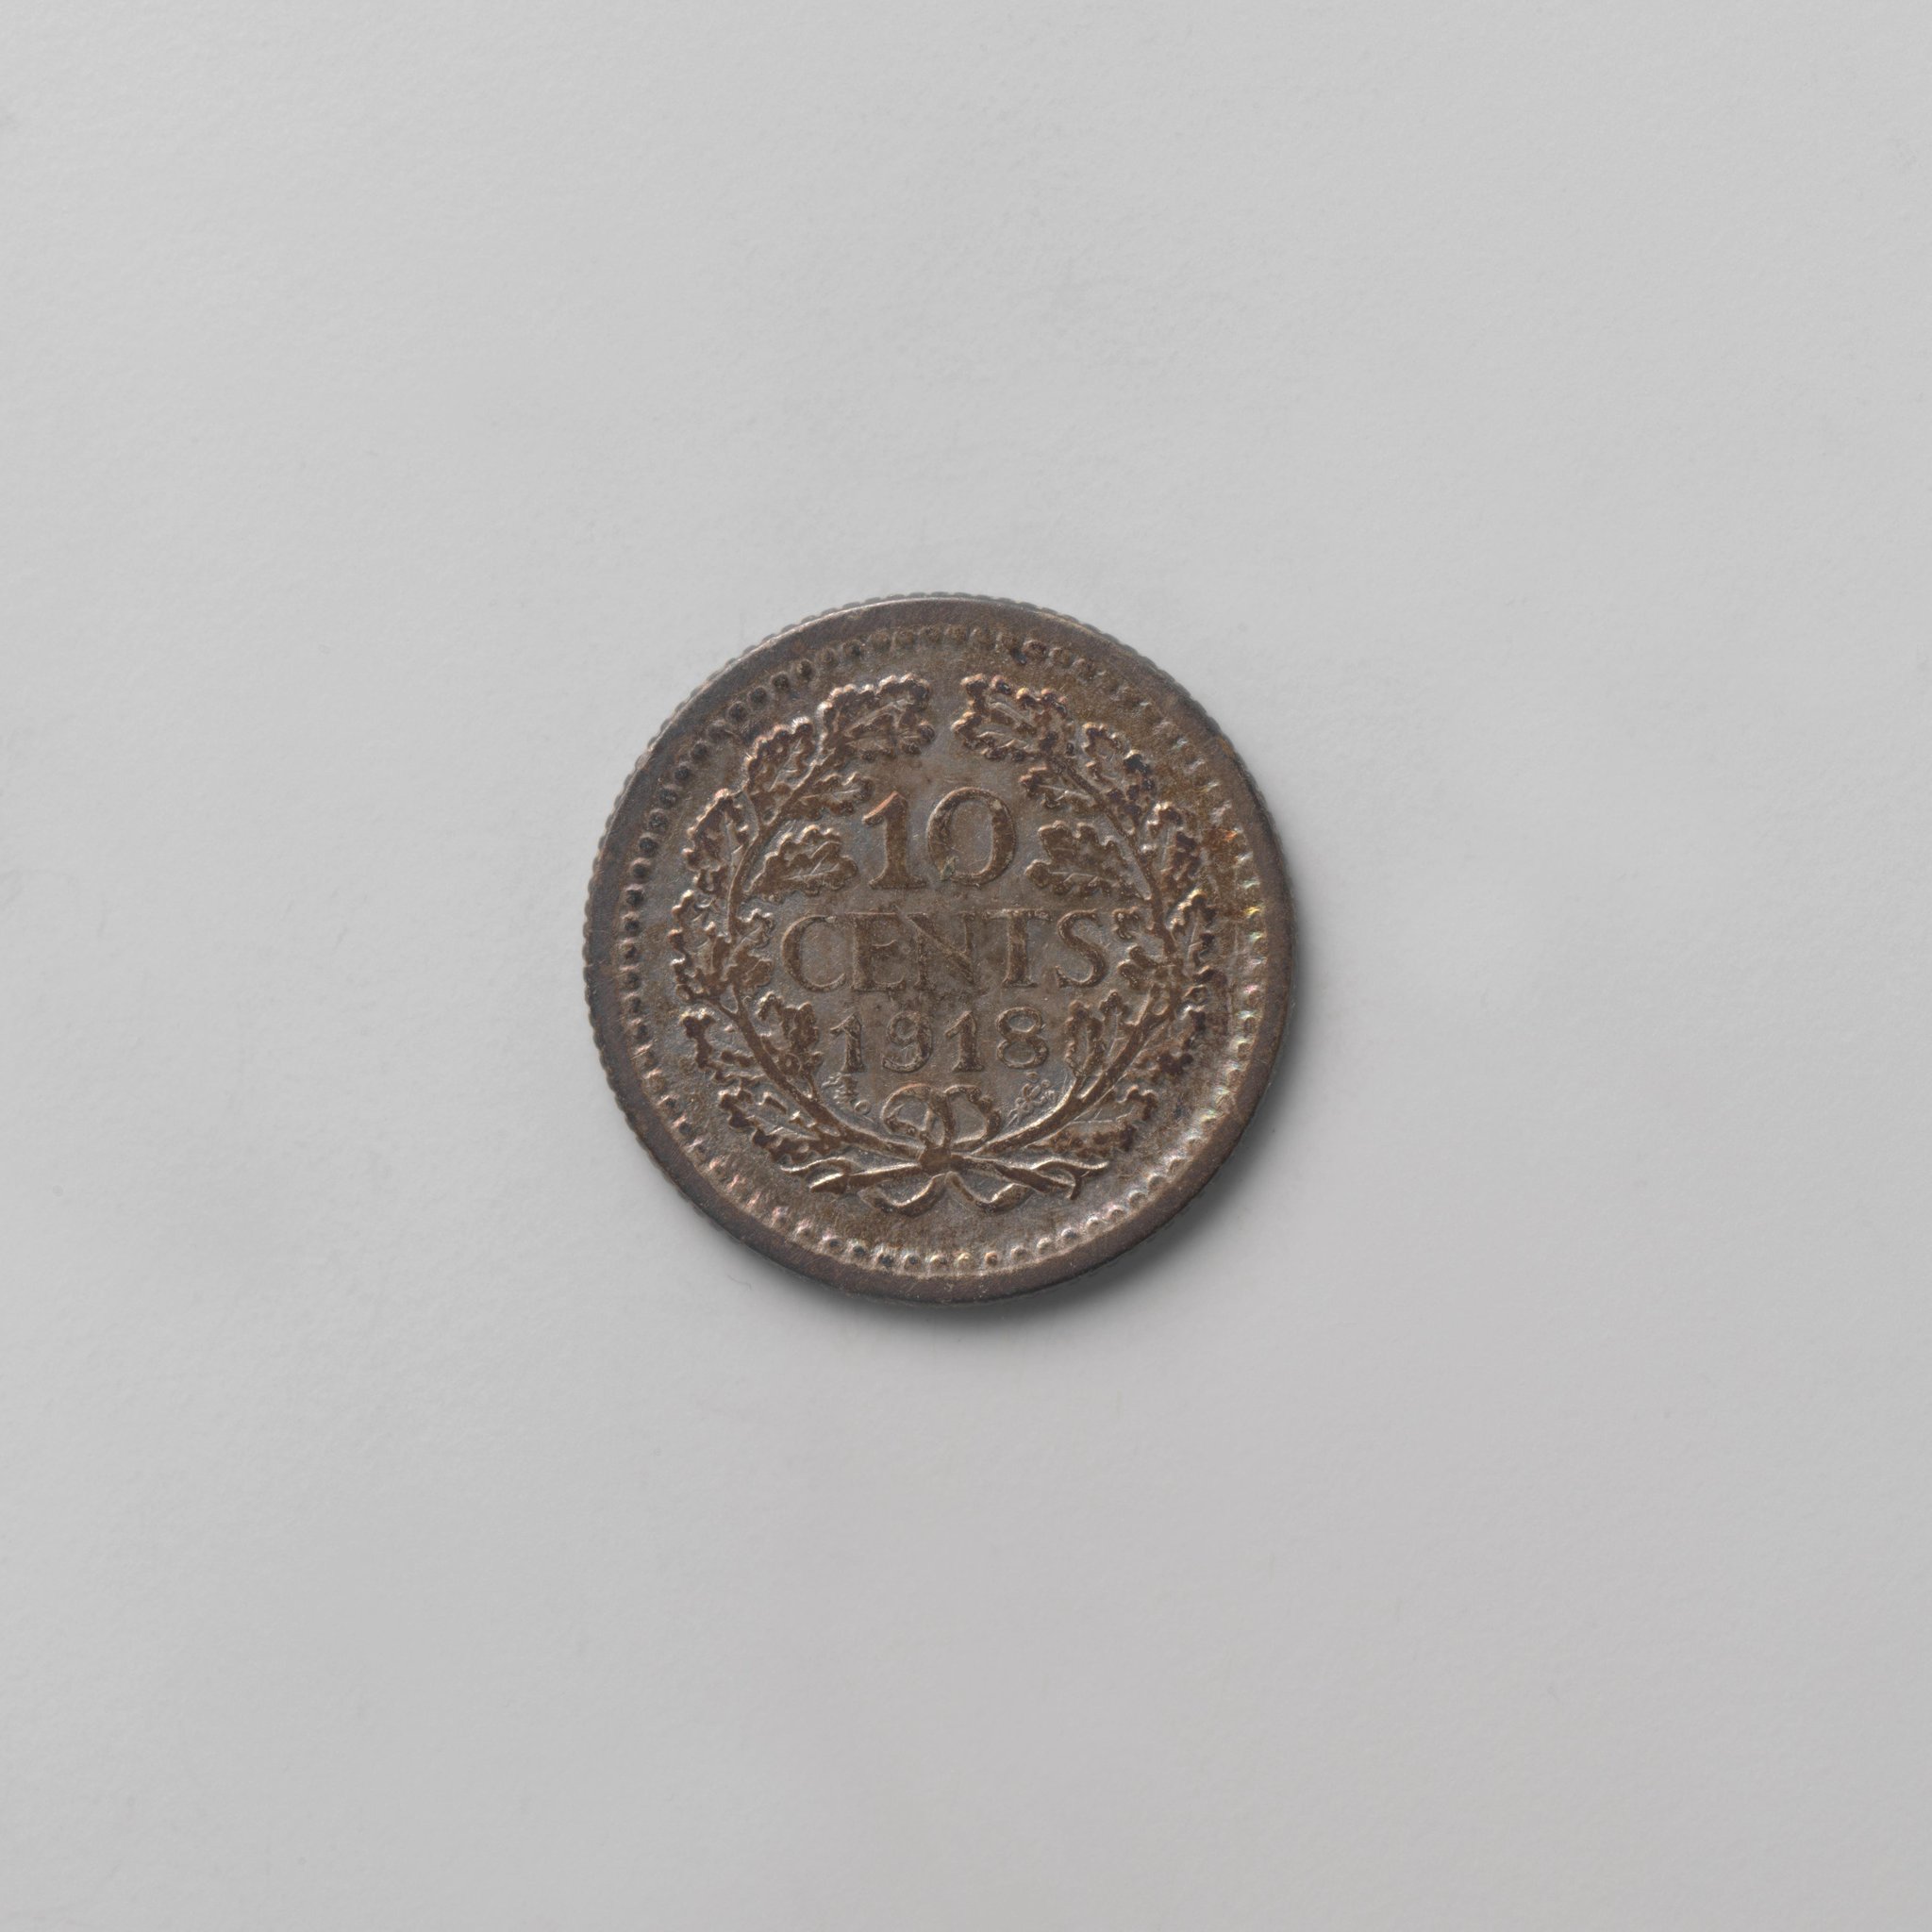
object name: coin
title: Nederland,10 cent,1918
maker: wilhelmina of the netherlands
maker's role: print maker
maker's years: 1880-1962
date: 1918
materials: silver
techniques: striking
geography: utrecht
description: Zilveren munt. Voorzijde: gedrapeerd borstbeeld naar links. Keerzijde: binnen twee samengebonden eiketakken waarde-aanduiding 10 cents en jaartal. Kartelrand.